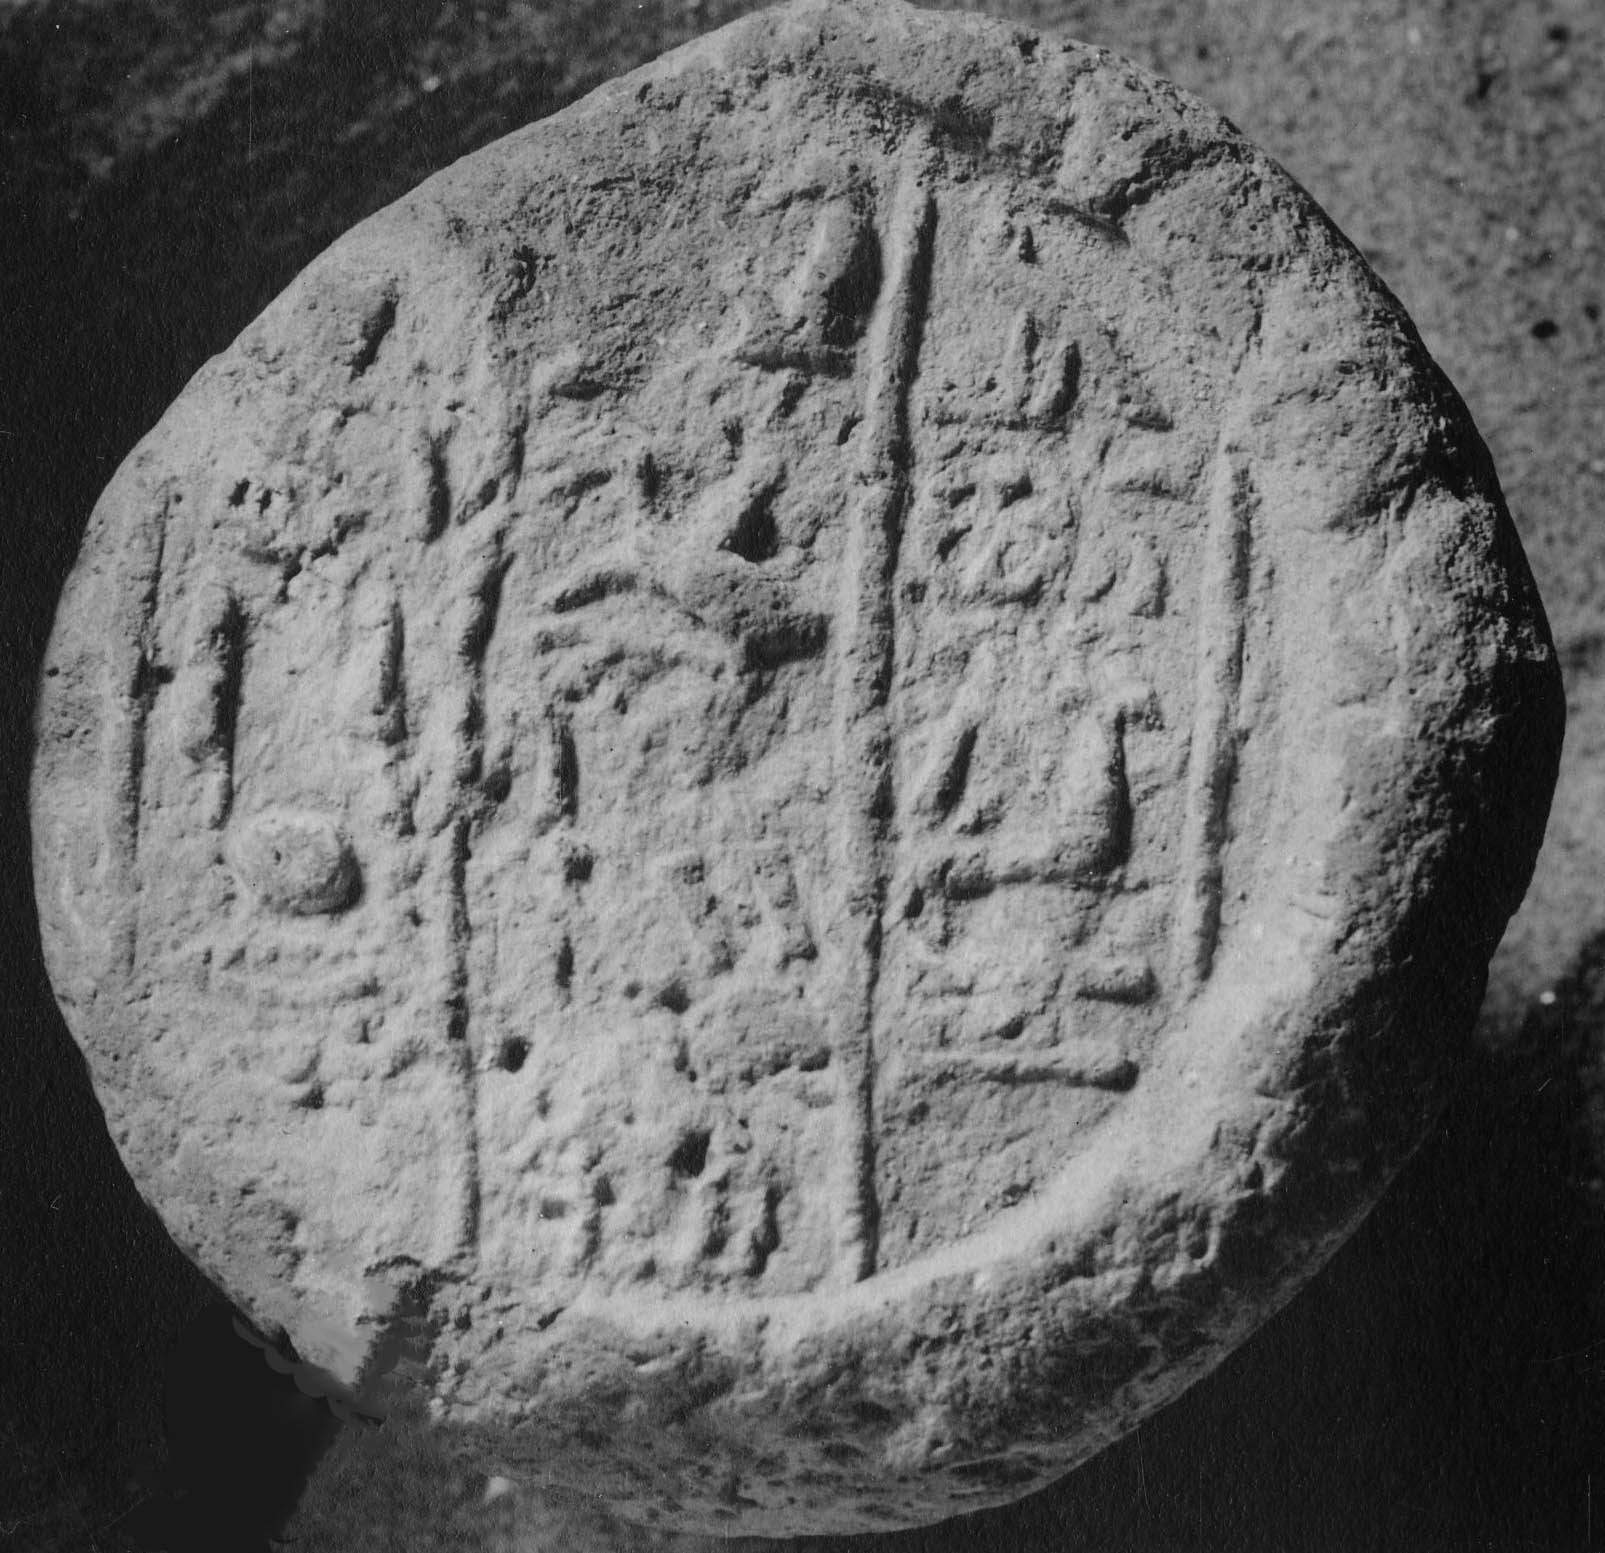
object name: cone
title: Funerary Cone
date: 1550-1295 BCE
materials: pottery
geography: egypt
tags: hieroglyphs